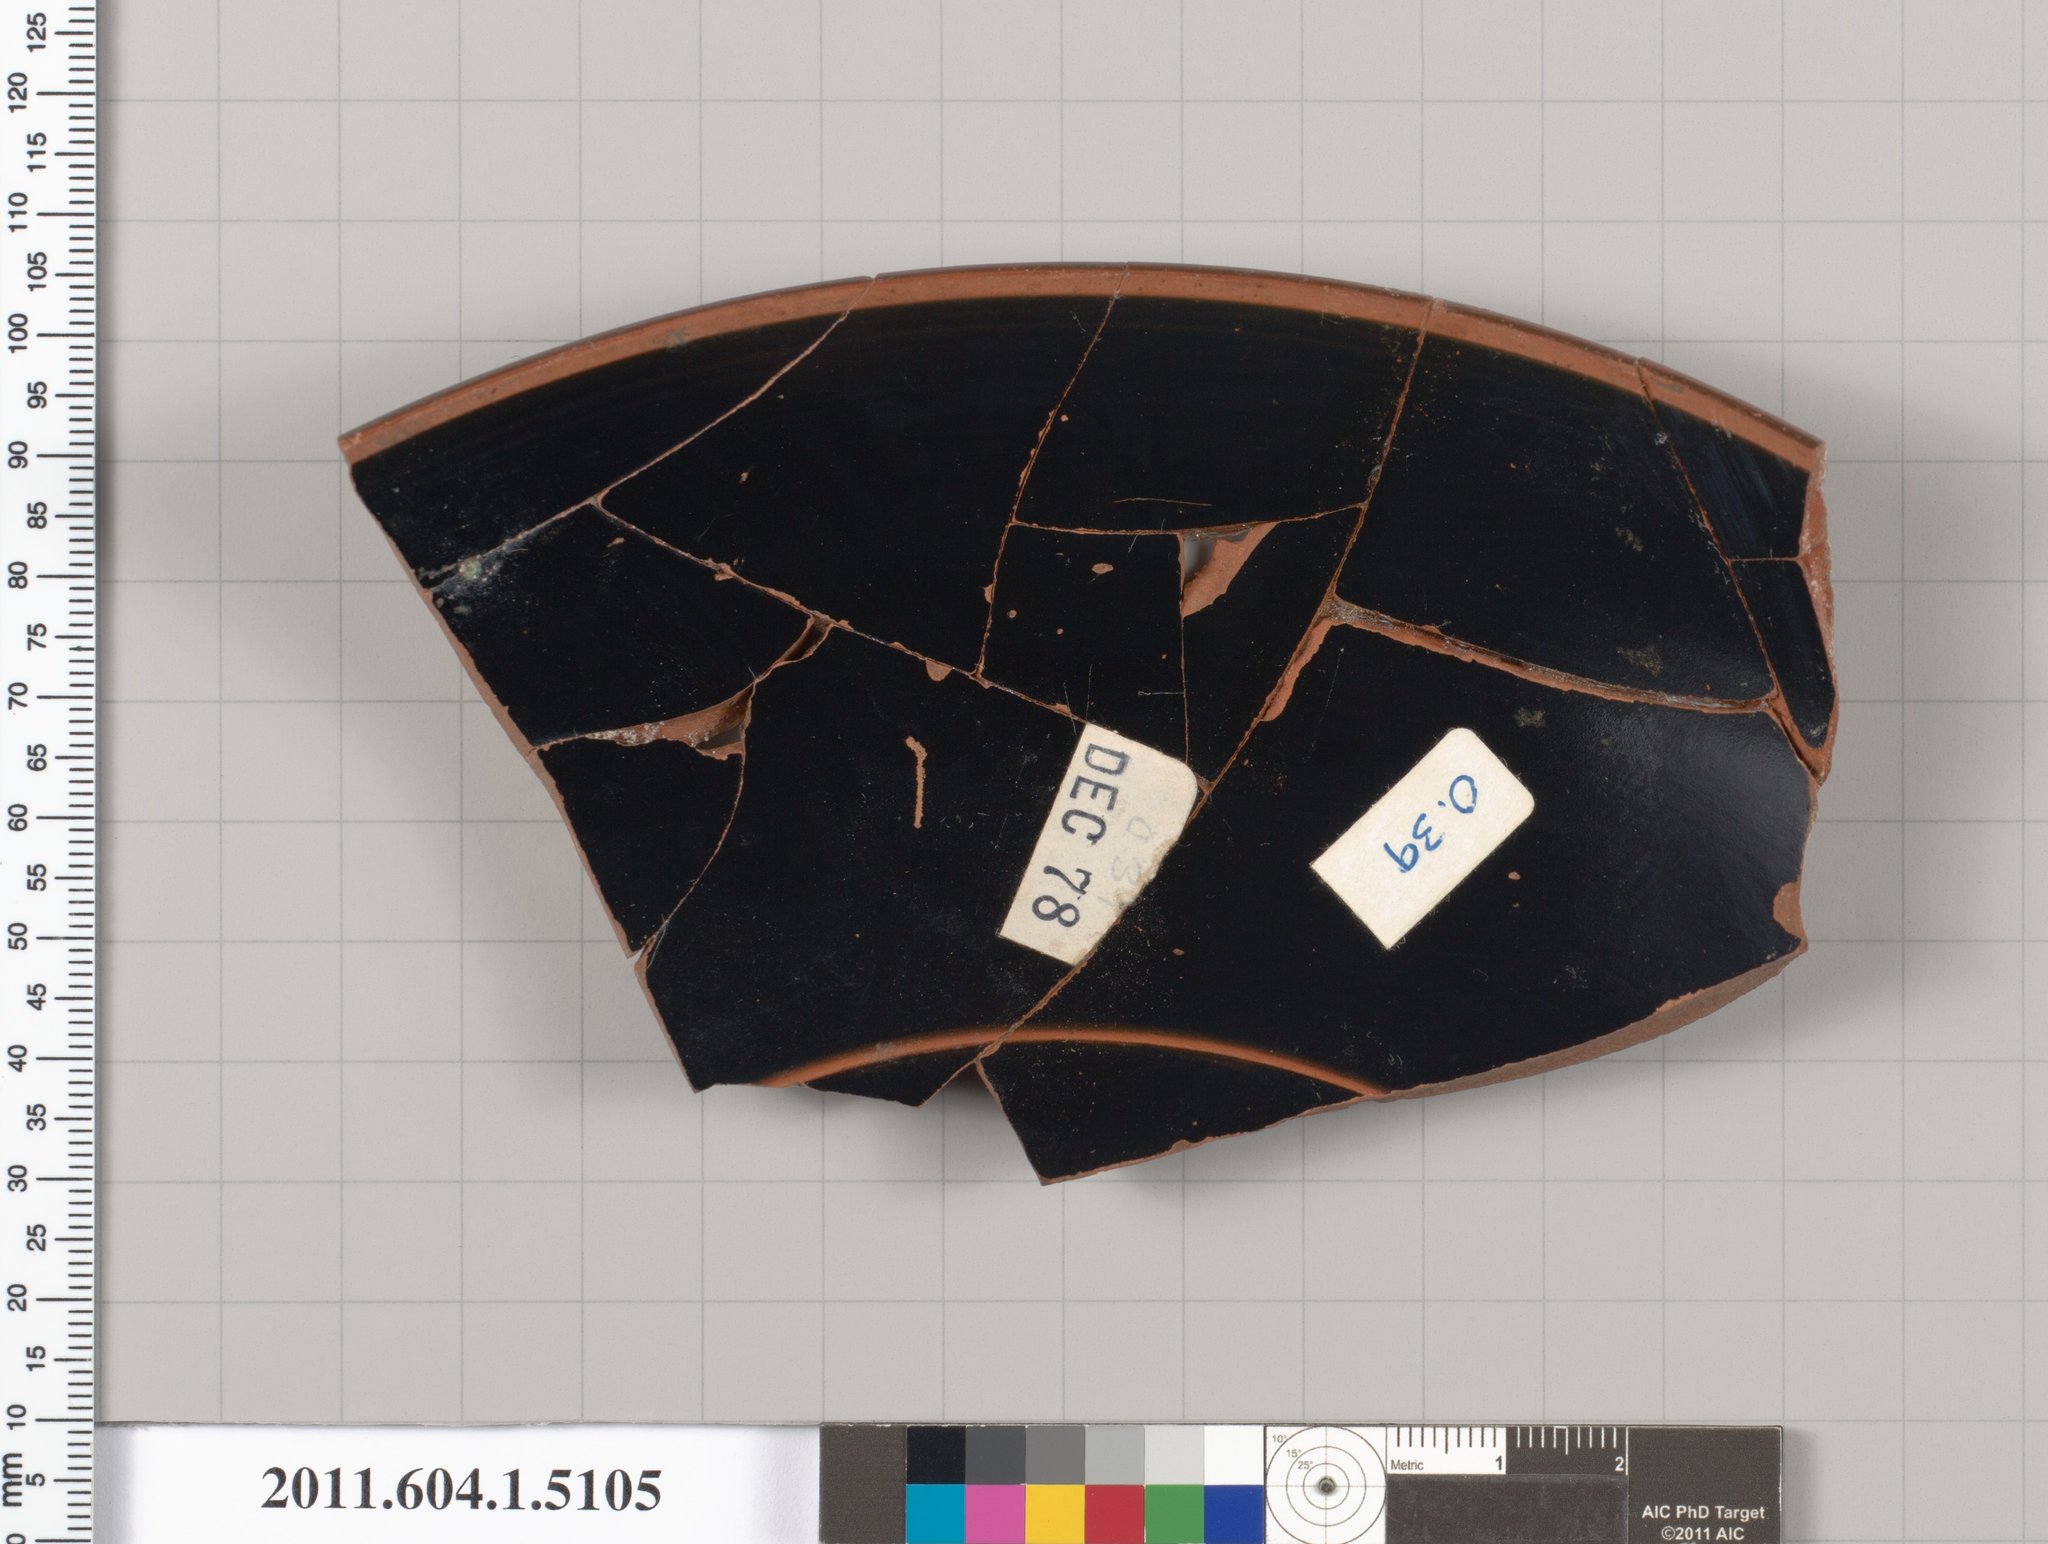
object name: kylix fragment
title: Terracotta rim fragment of a kylix (drinking cup)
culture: greek, attic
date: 510-500 BCE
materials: terracotta